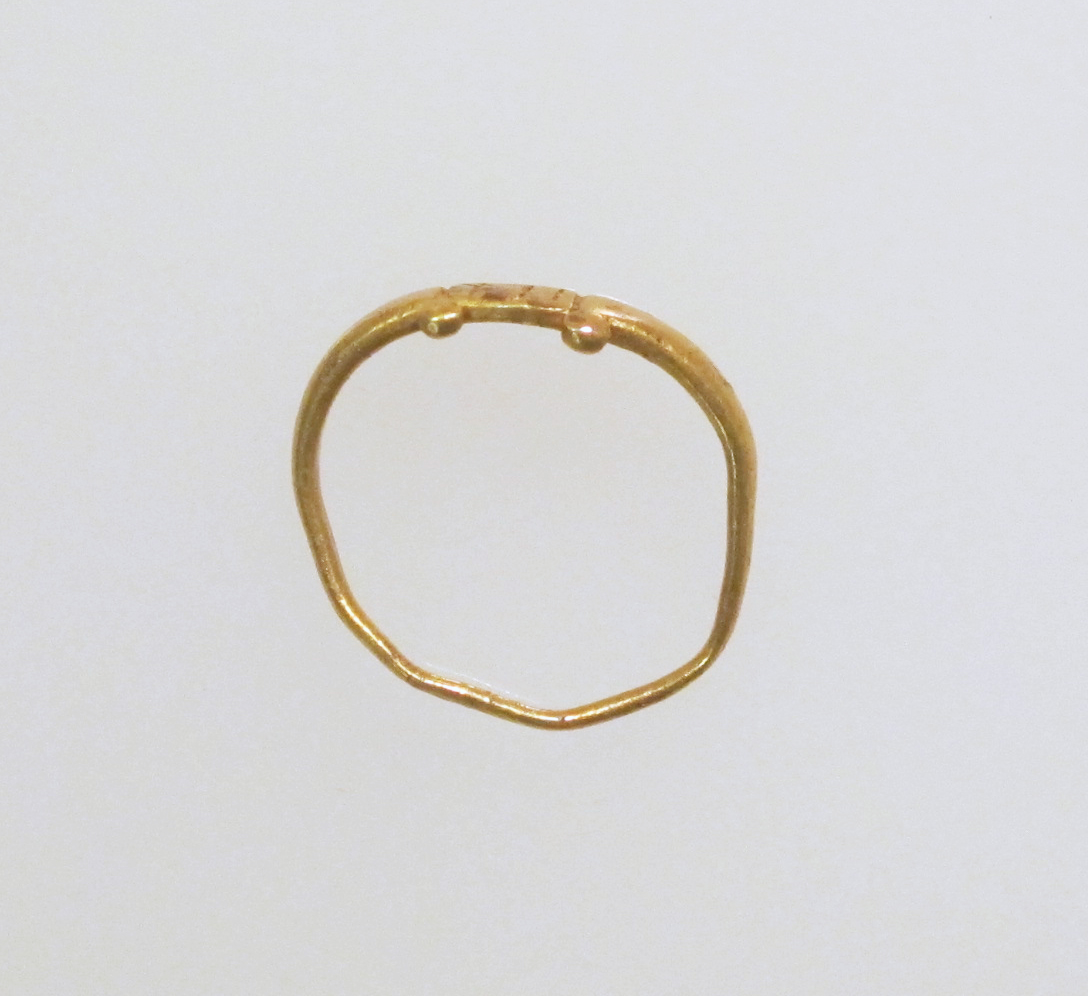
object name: ring, inscribed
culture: etruscan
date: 900-100 BCE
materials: gold